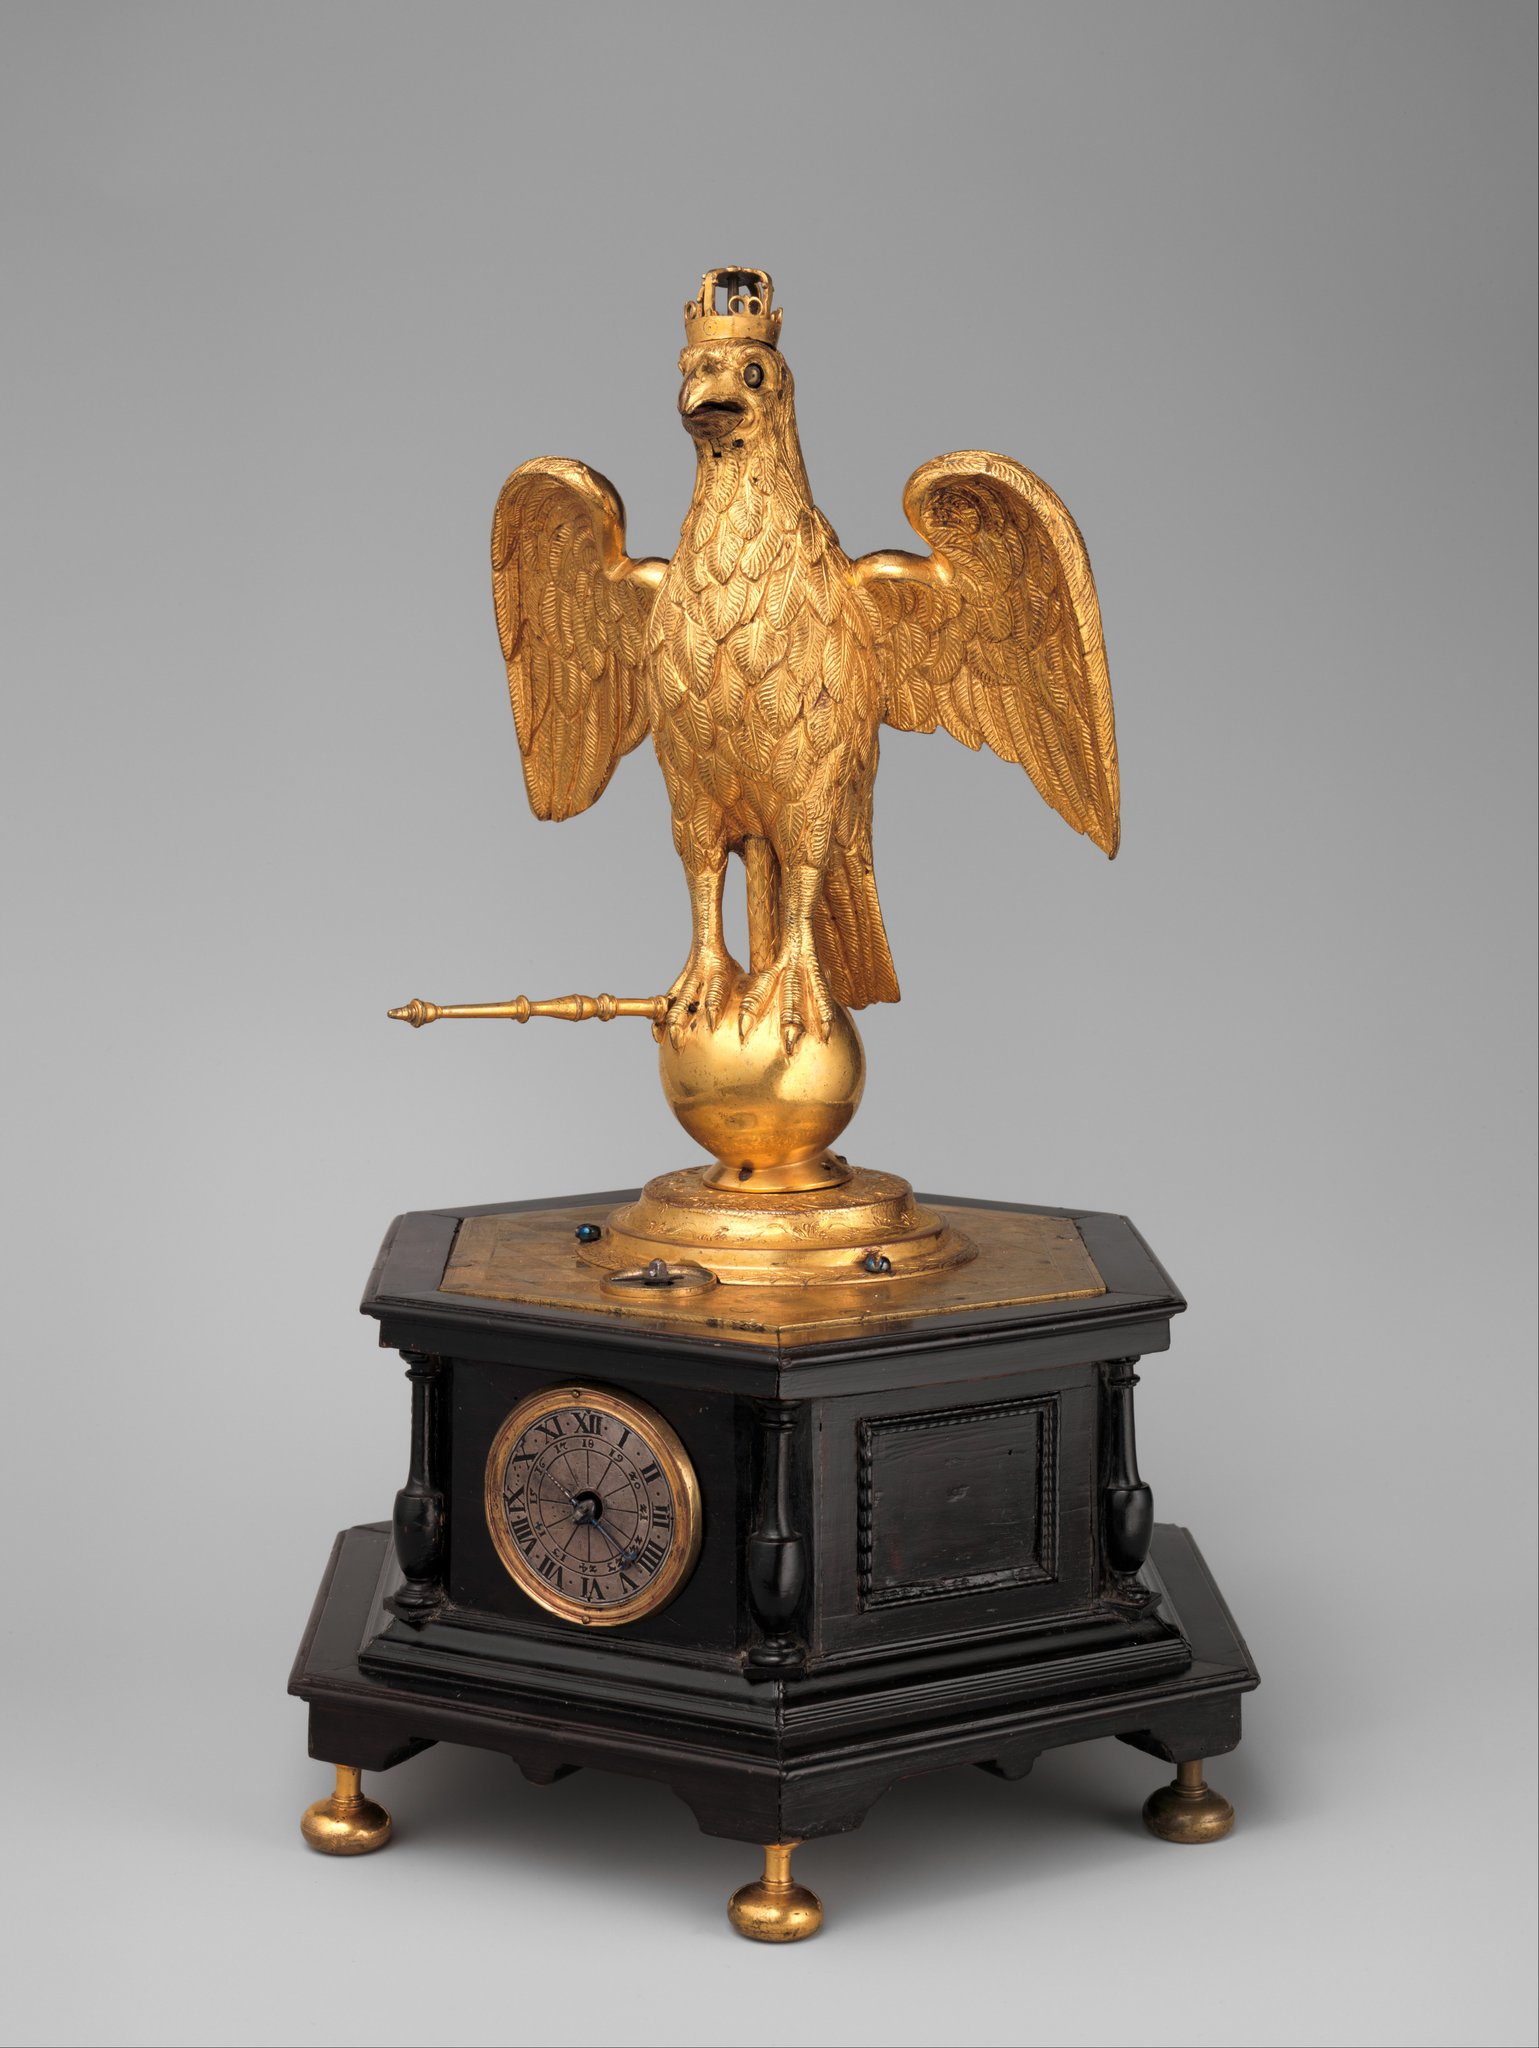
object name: automaton clock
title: Automaton clock in the form of an eagle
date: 1630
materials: brass, wood, gilt brass, iron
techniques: veneering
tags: eagles,snakes